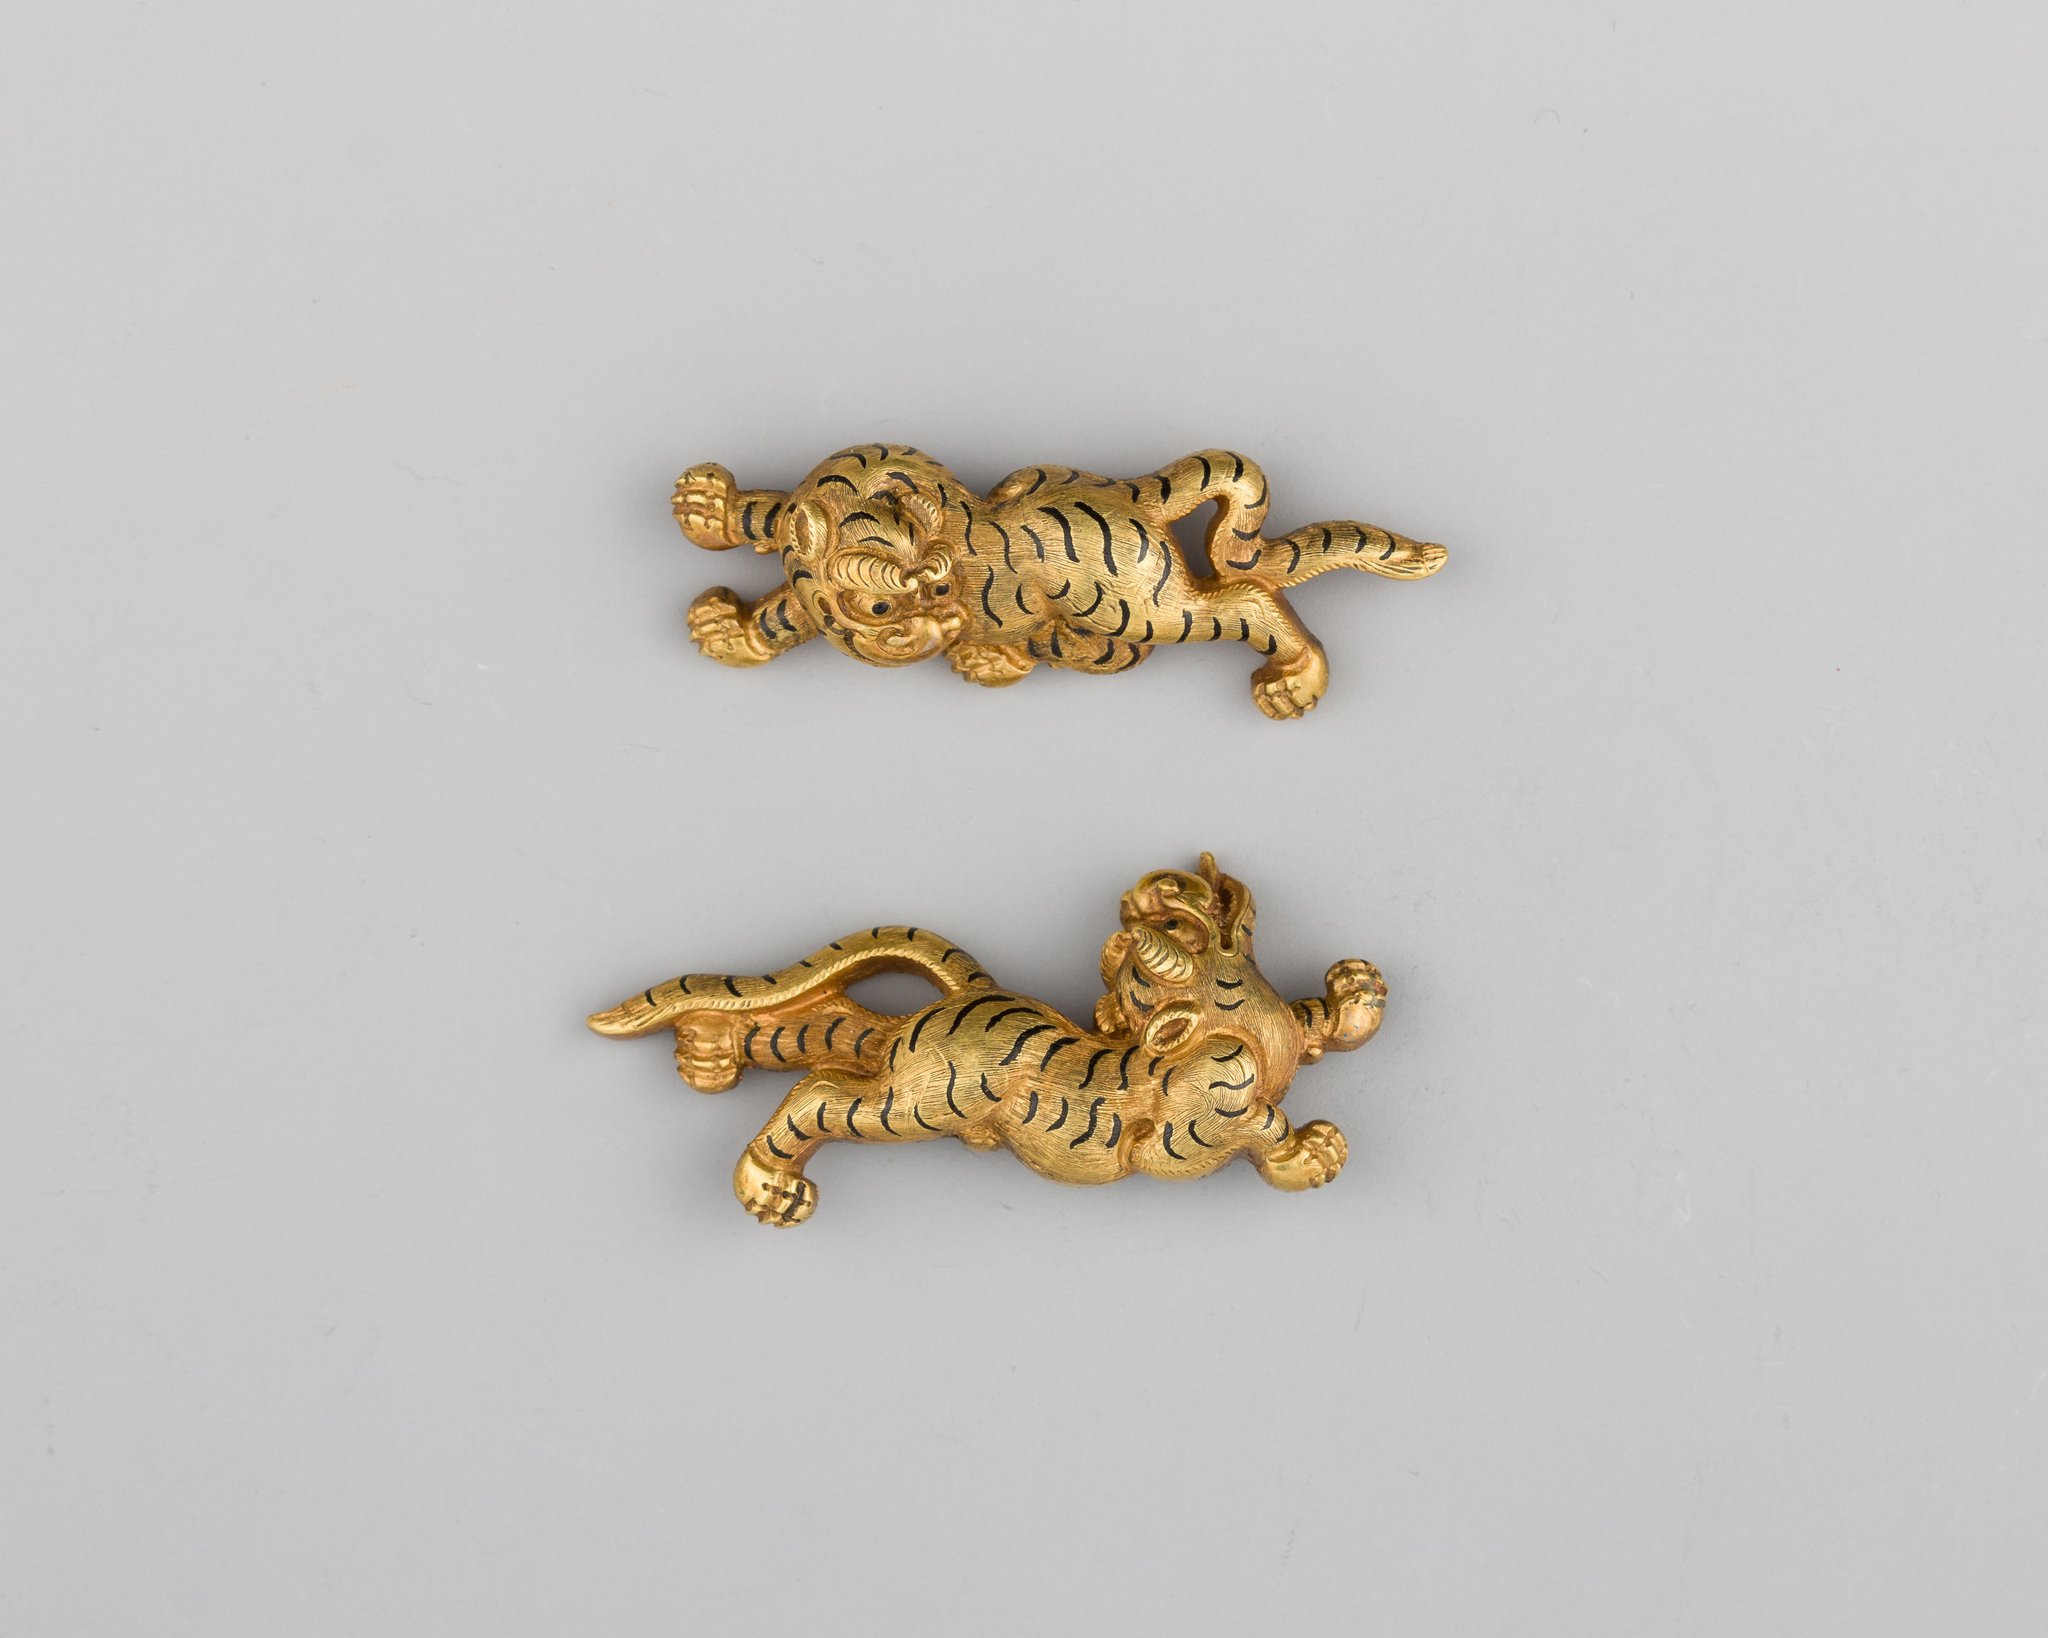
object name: pair of sword grip ornament menuki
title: Pair of Sword-Grip Ornaments (Menuki)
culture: japanese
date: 1720-1784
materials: gold alloy, gold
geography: japan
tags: tigers